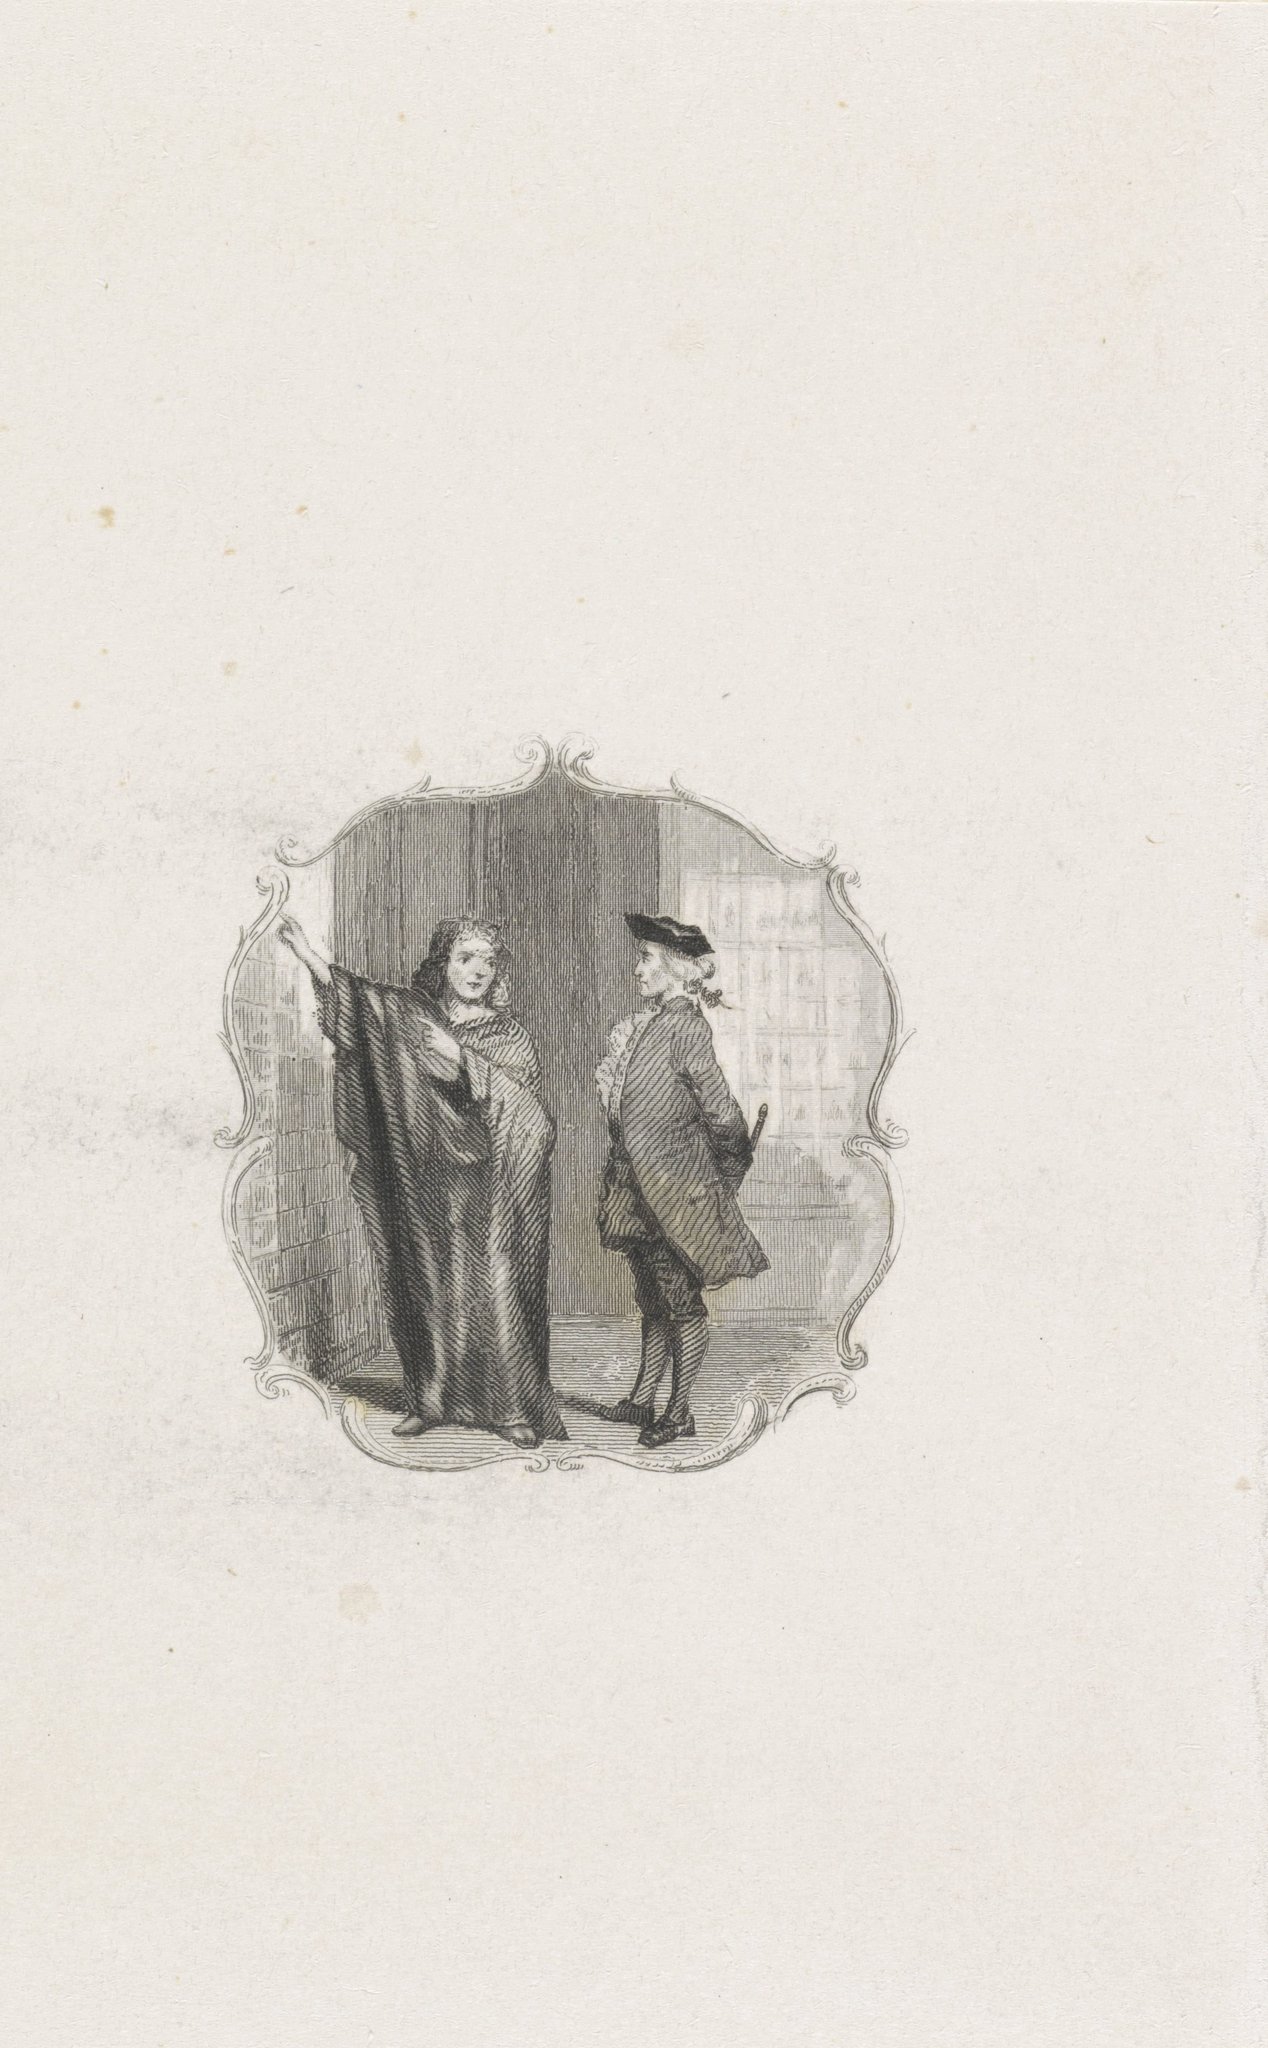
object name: print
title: Twee figuren in een interieur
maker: willem frederik wehmeyer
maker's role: print maker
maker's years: 1819-1854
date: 1854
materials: paper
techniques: engraving, etching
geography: amsterdam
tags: adult woman, adult man, interior of the house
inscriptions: collector's mark: Lugt 2228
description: In een interieur staat een man bij een vrouw, die naar een wand wijst , De voorstelling wordt door voluten omgeven. Mogelijk bedoeld als illustratie op een titelpagina.